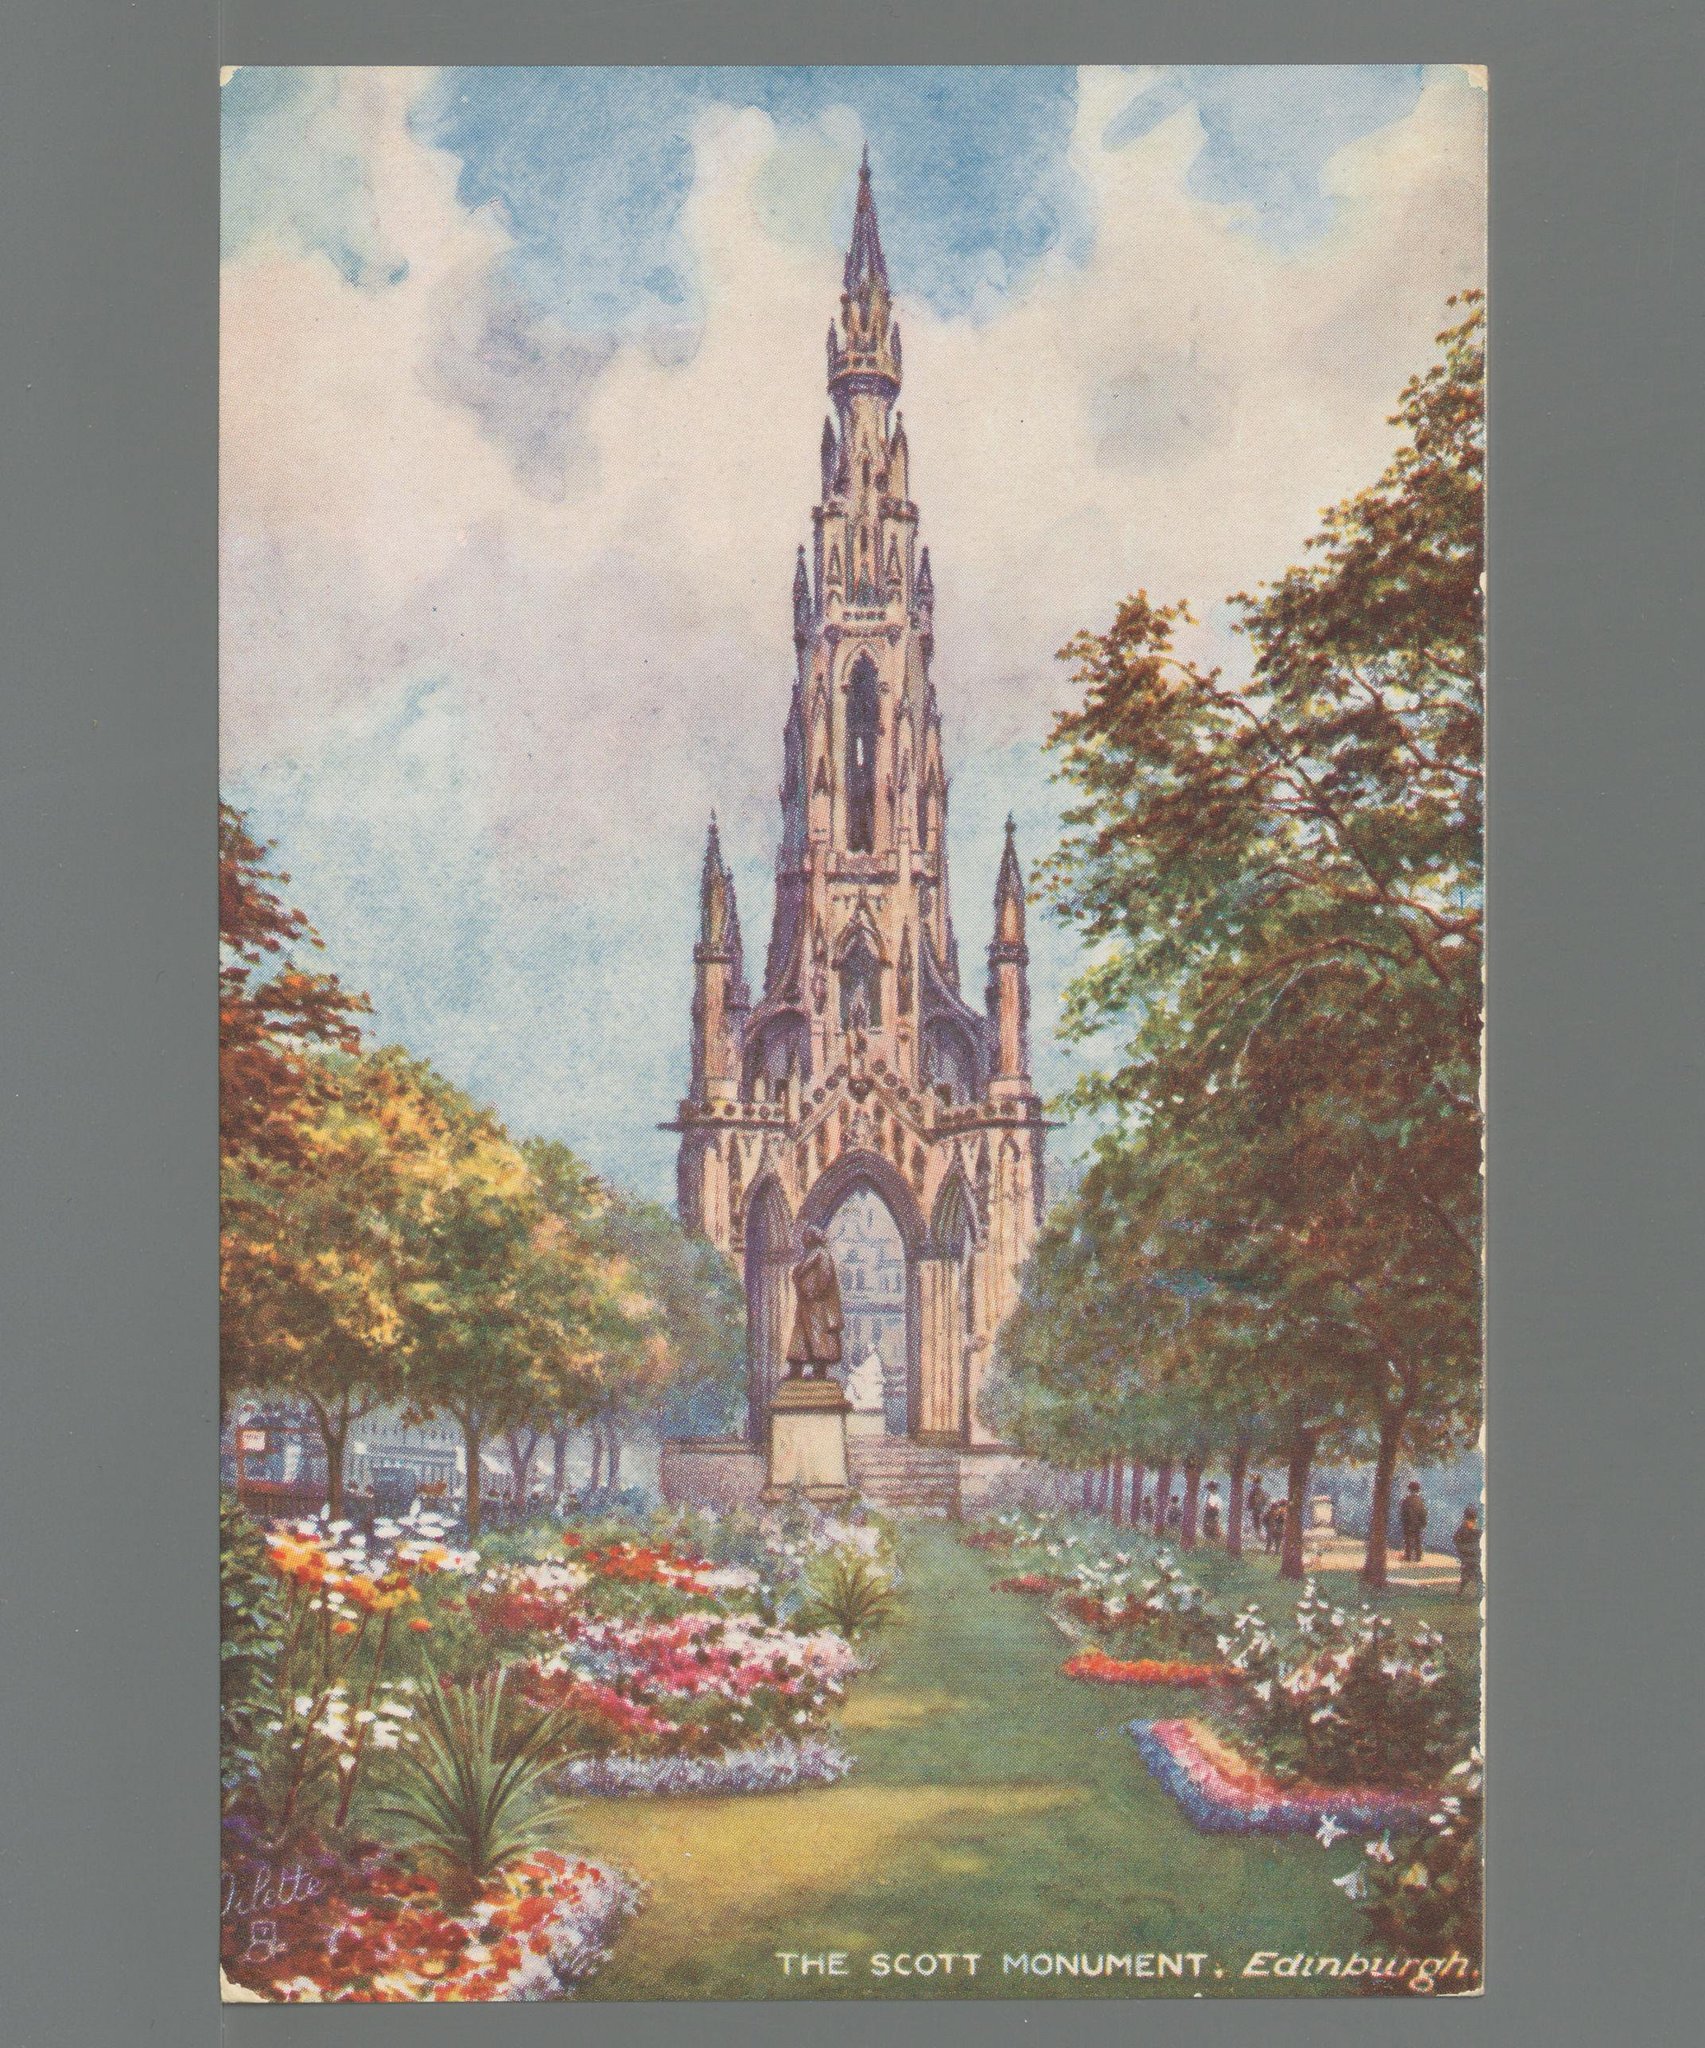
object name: photomechanical print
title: Edinburgh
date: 1902-1905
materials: cardboard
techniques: color autotype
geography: london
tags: garden, monument, statue